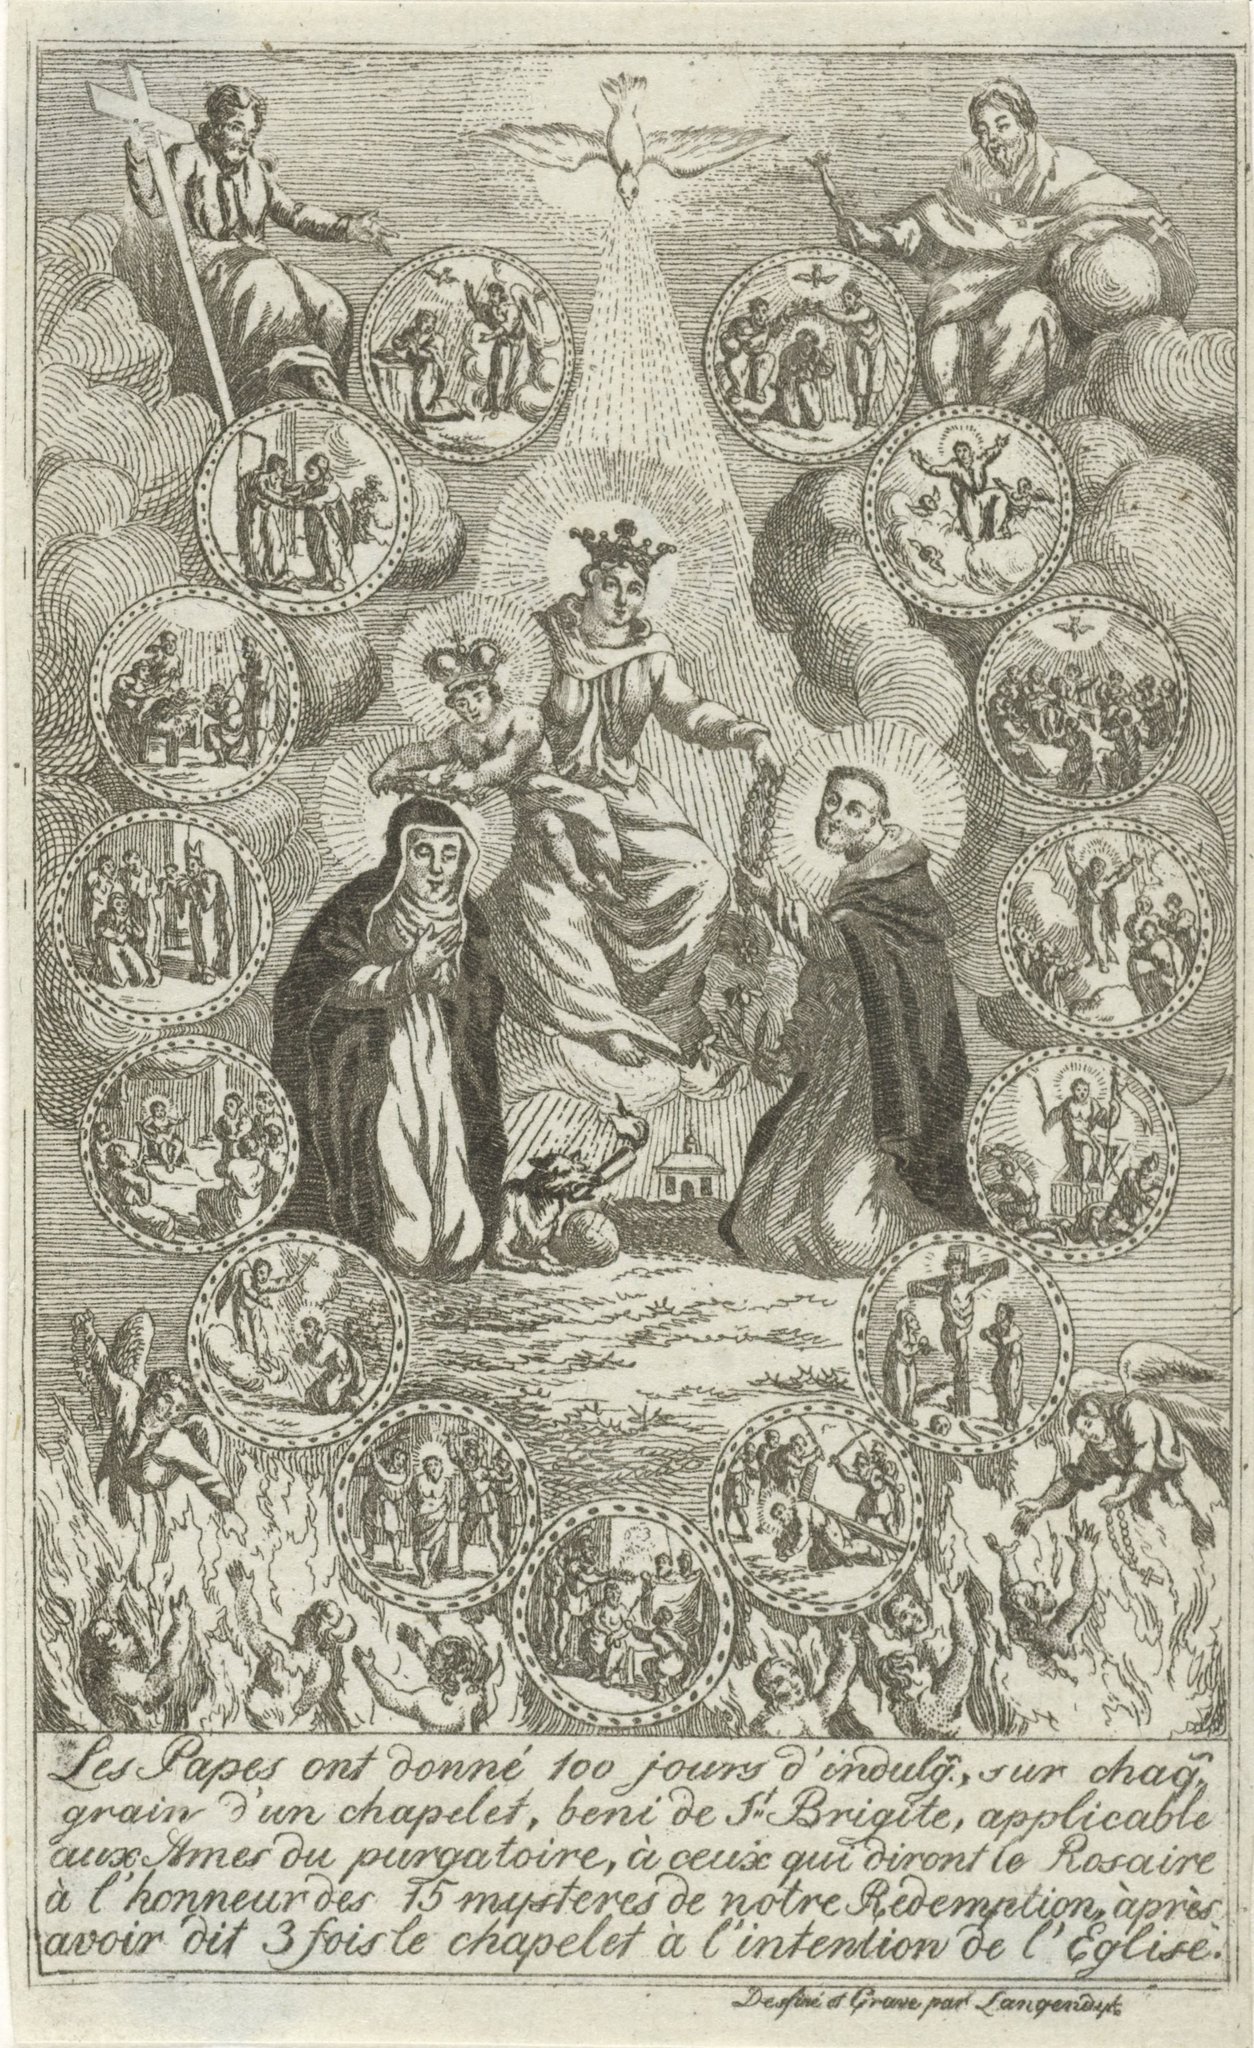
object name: print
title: Maria met kind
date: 1693-1756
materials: paper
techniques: etching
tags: christ-child winding a crown of thorns, or with thorny twigs, aids for prayer, e.g. rosary, mary sitting or enthroned, the christ-child in front of her, sitting in her lap (or in front of her bosom), holy ghost represented as a dove (in flames)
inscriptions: collector's mark: Lugt 2760, collector's mark: Lugt 2228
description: Maria zit met het Christuskind op schoot, beiden zijn gekroond. Aan weerszijden van Maria en Kind knielen een man en vrouw. De vrouw wordt door het Christuskind gekroond met een doornenkrans, de man ontvangt van Maria een rozenkrans. Rond het viertal medaillons met bijbelse scènes. Centraal bovenin prijkt een duif, het christelijke symbool voor de Heilige Geest. In de marge staat een vijfregelig onderschrift in het Frans.